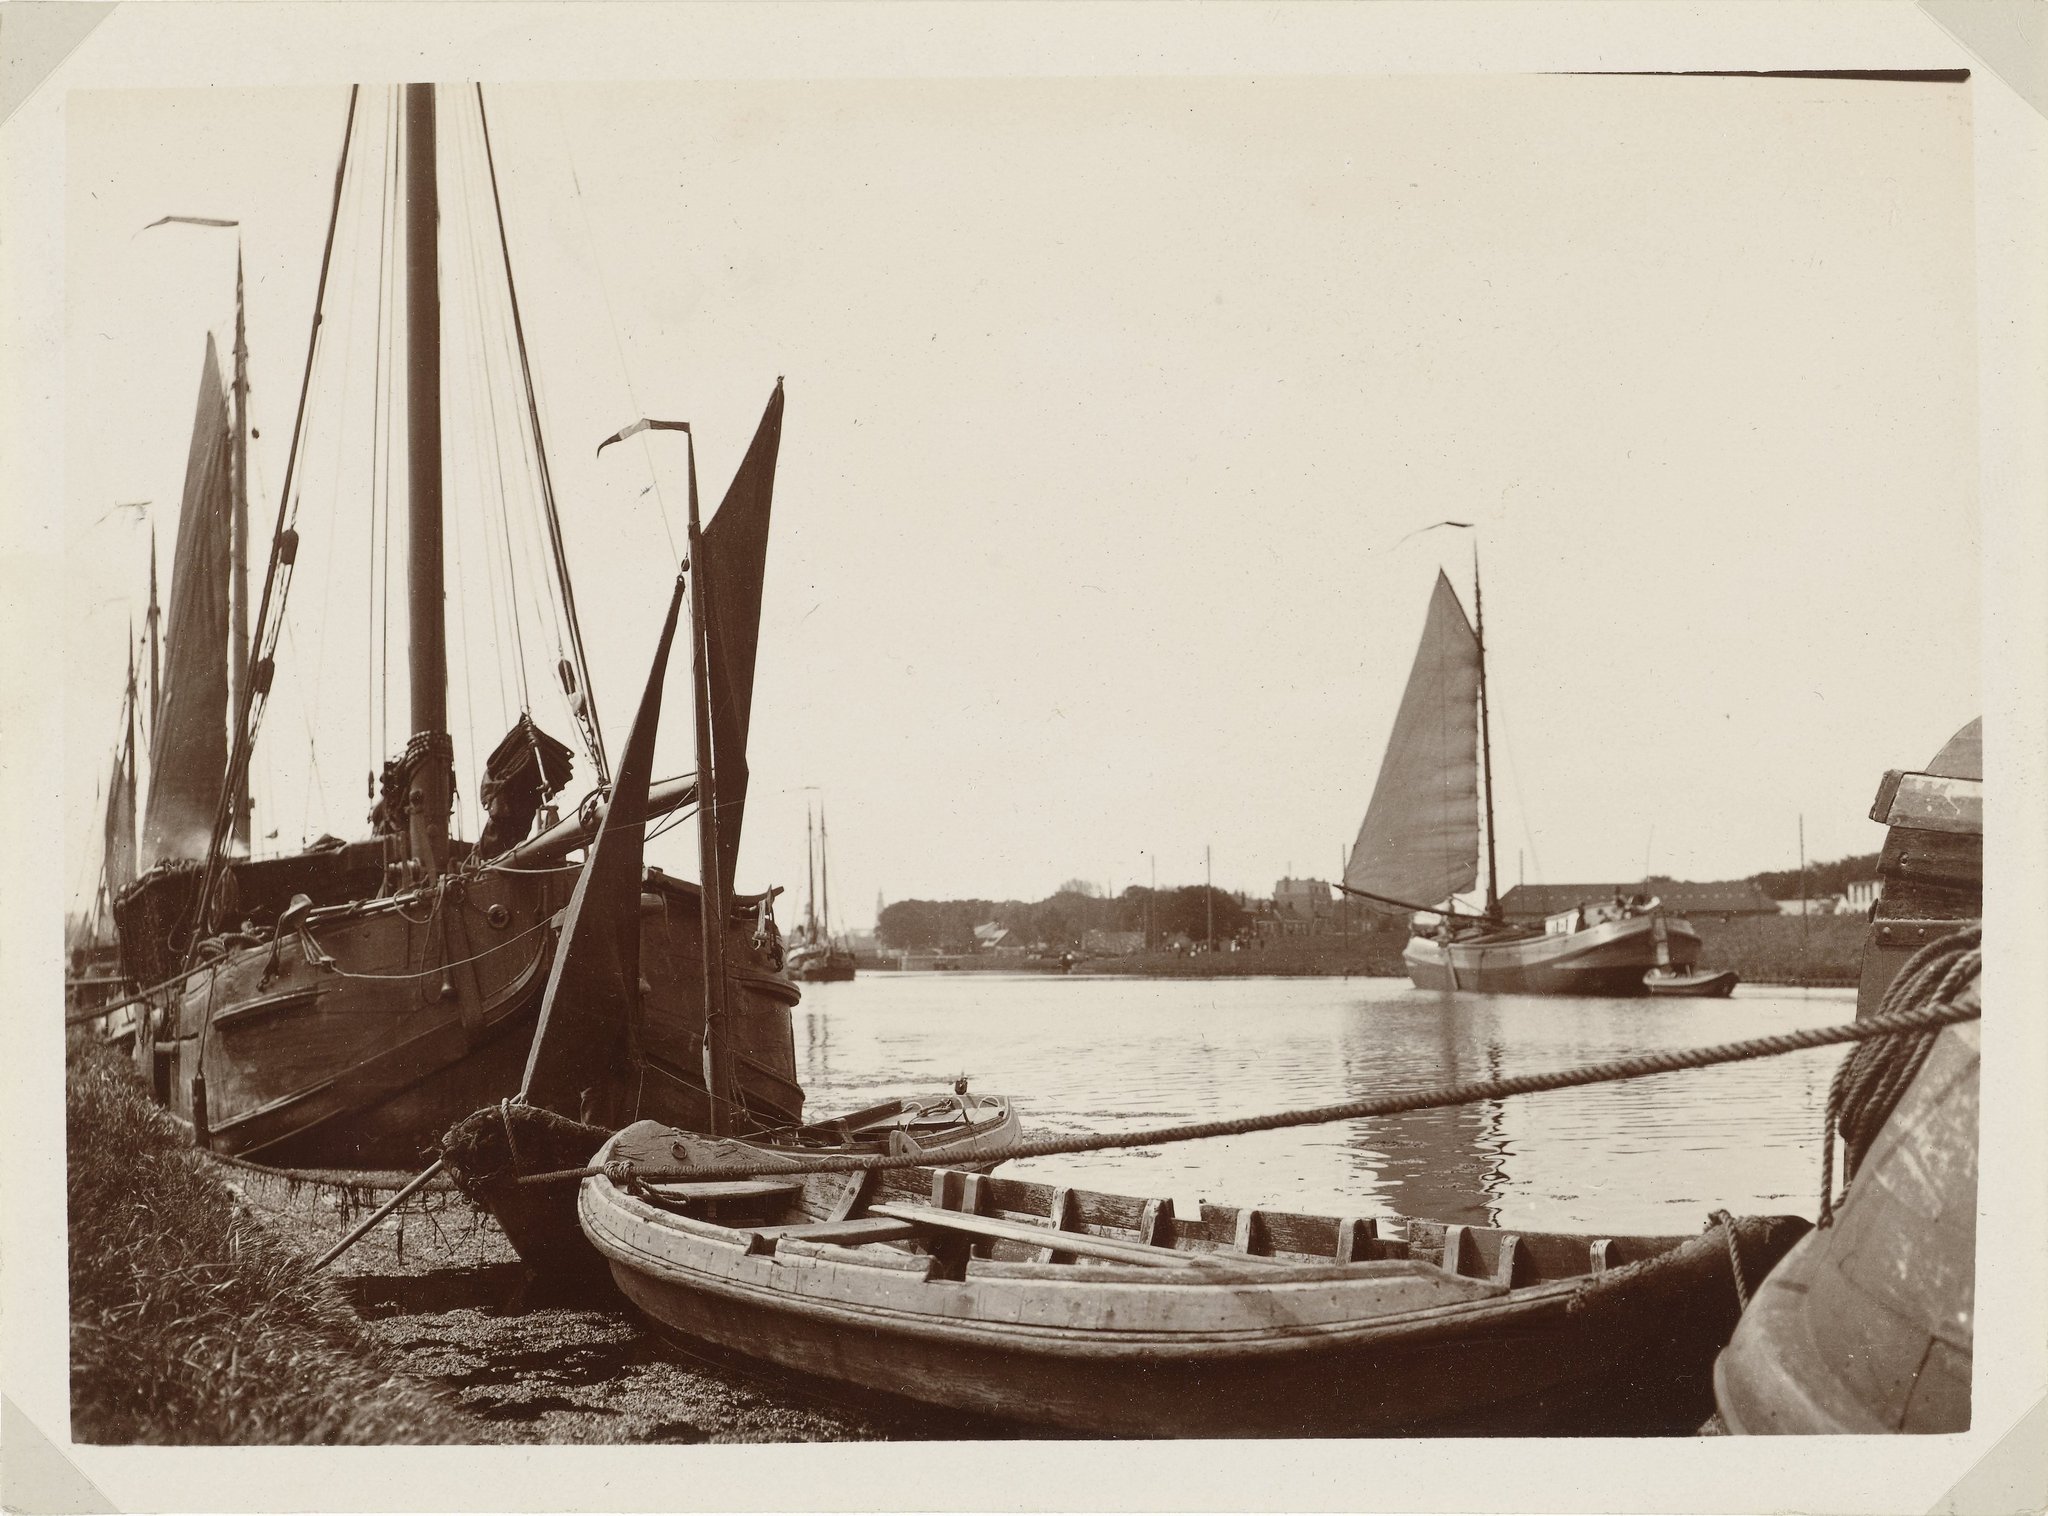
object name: photograph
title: North Holland Canal (?)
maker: james higson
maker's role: politician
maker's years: 1862-1933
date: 1904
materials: paper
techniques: gelatin silver print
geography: netherlands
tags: ships (in general) - cc - more than one ship